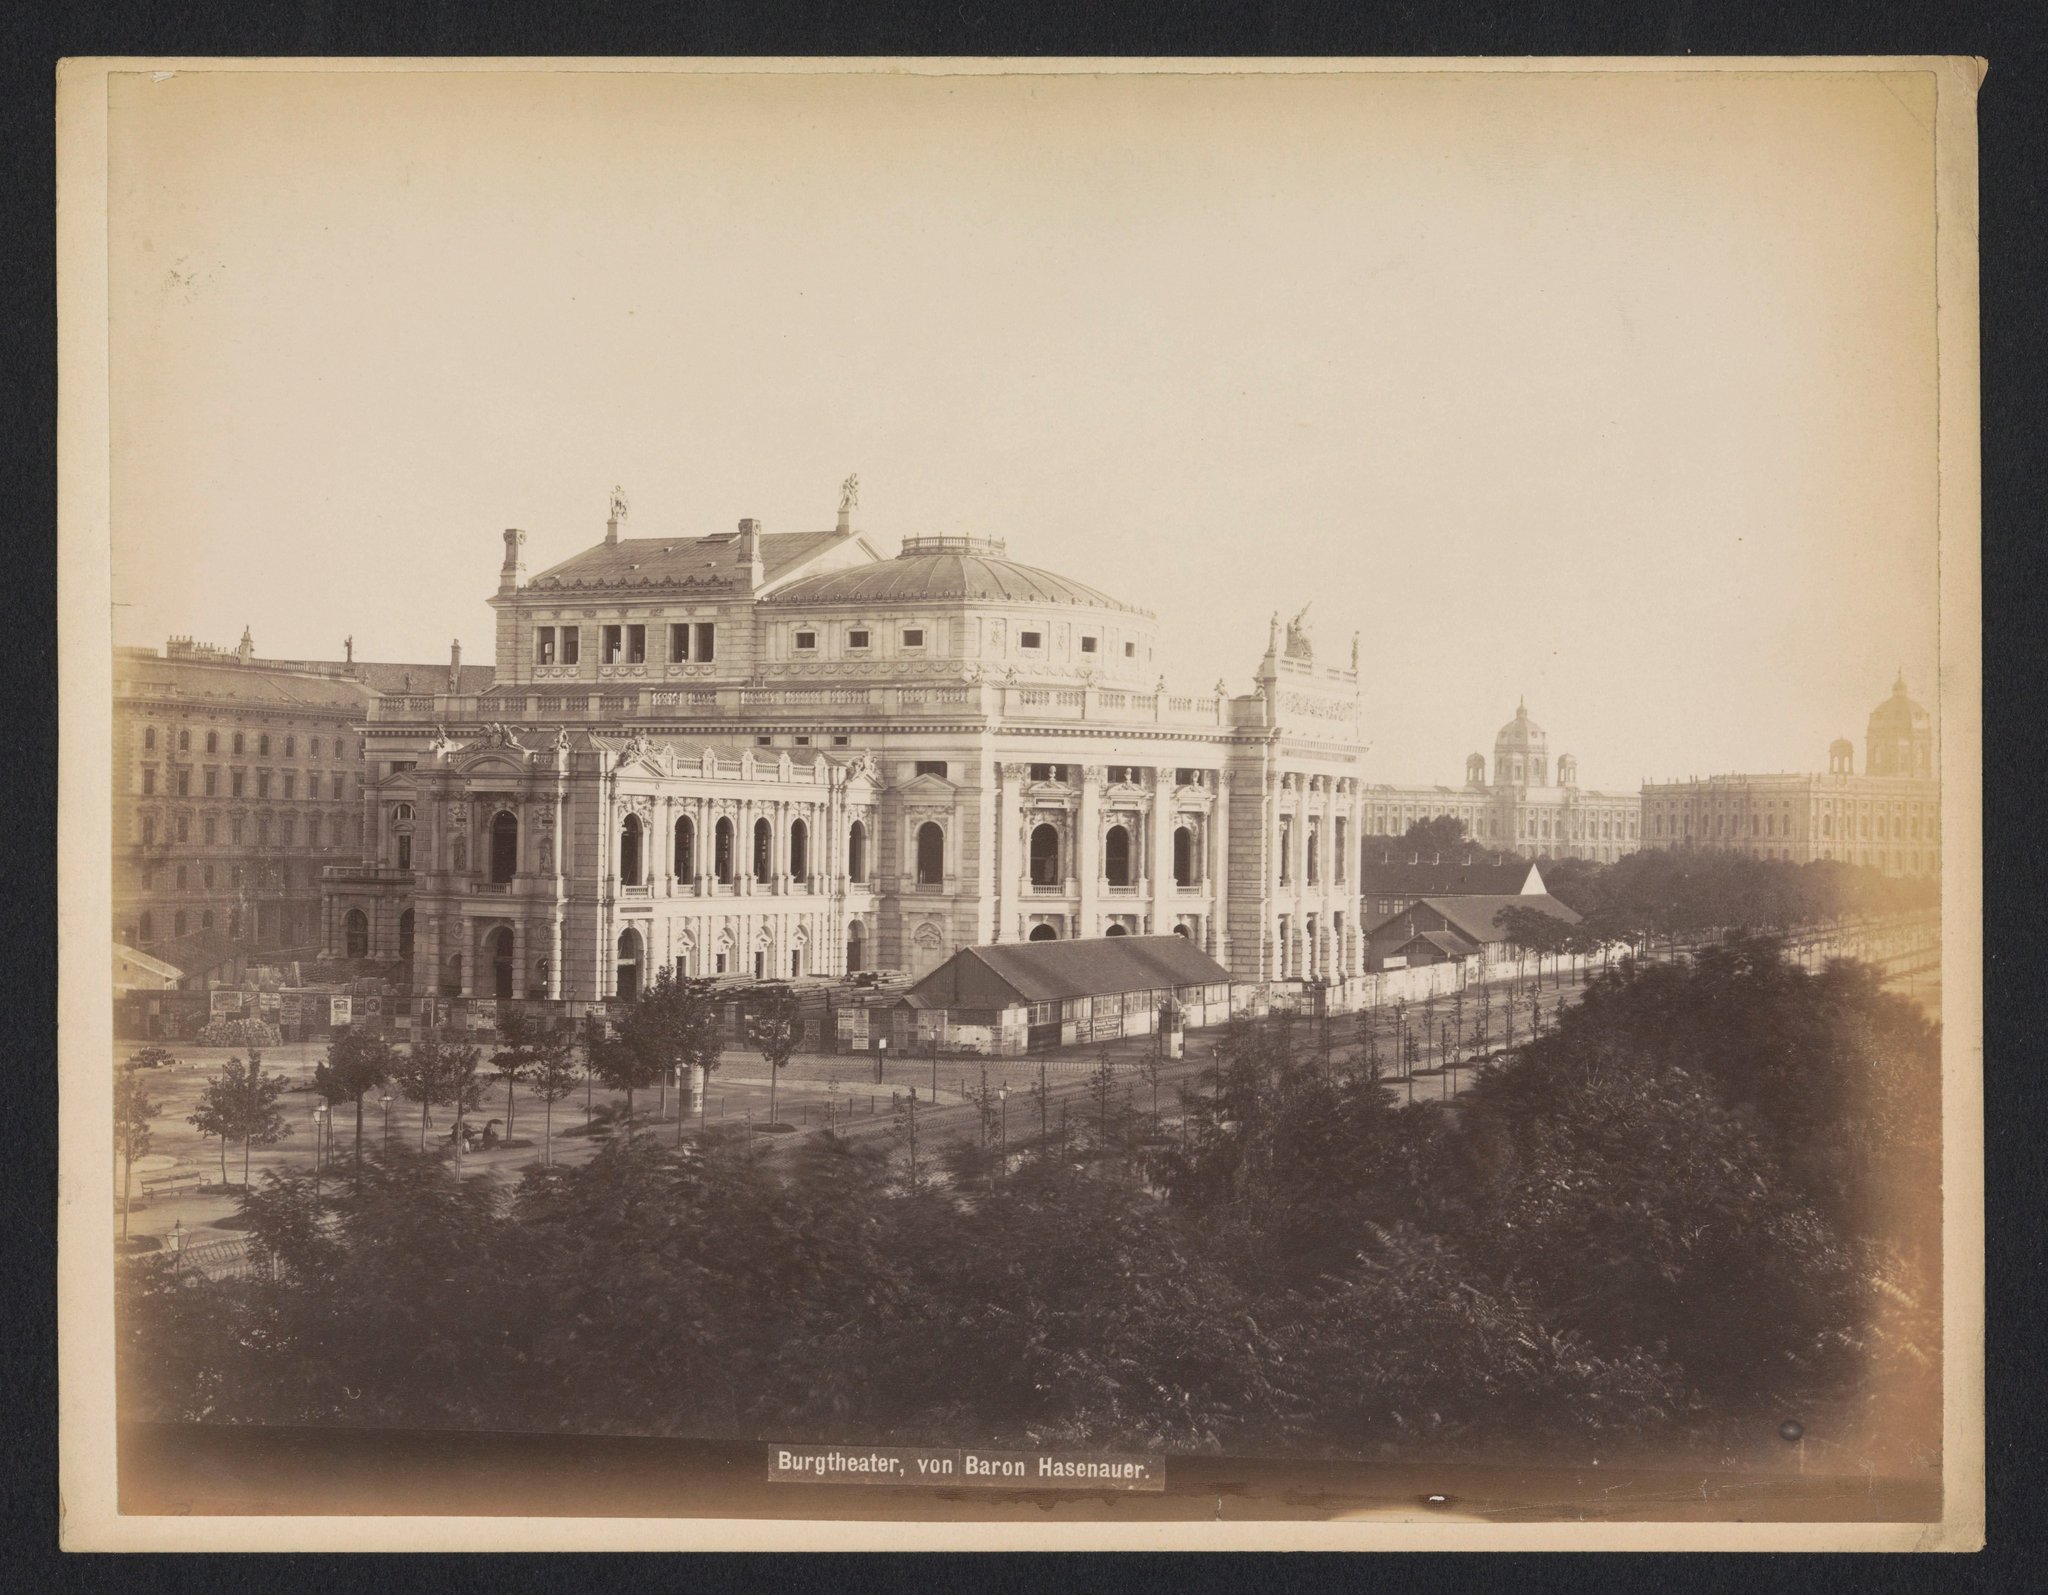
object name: photograph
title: Gezicht op het Burgtheater in Wenen, Oostenrijk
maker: Anonymous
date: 1851-1900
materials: cardboard, paper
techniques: albumen print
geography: vienna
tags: theatre (building), exterior ~ representation of a building